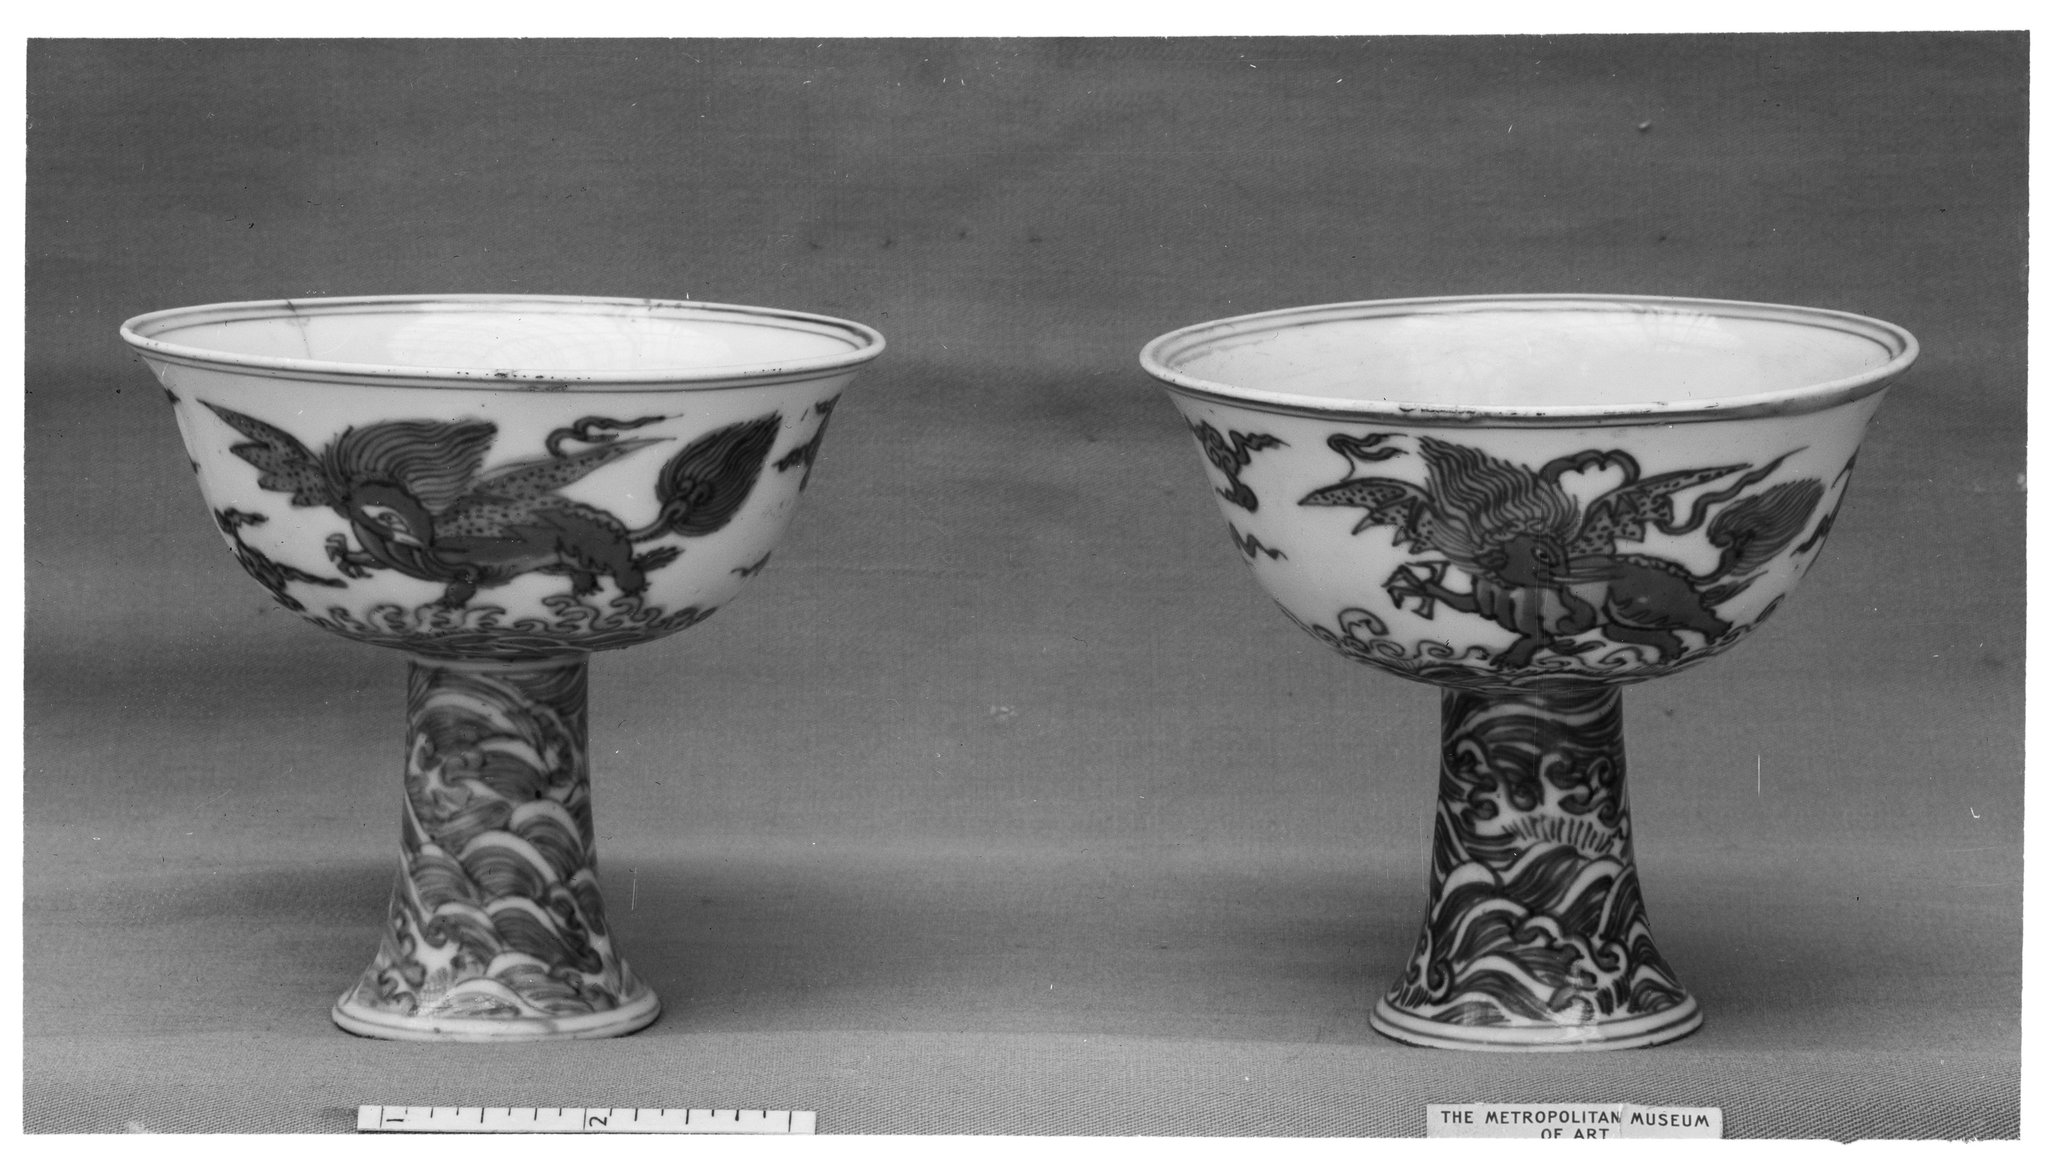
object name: pair of stem cup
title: Pair of Stem Cups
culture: chinese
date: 1573-1620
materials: porcelain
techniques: painting, underglaze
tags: mythical creatures